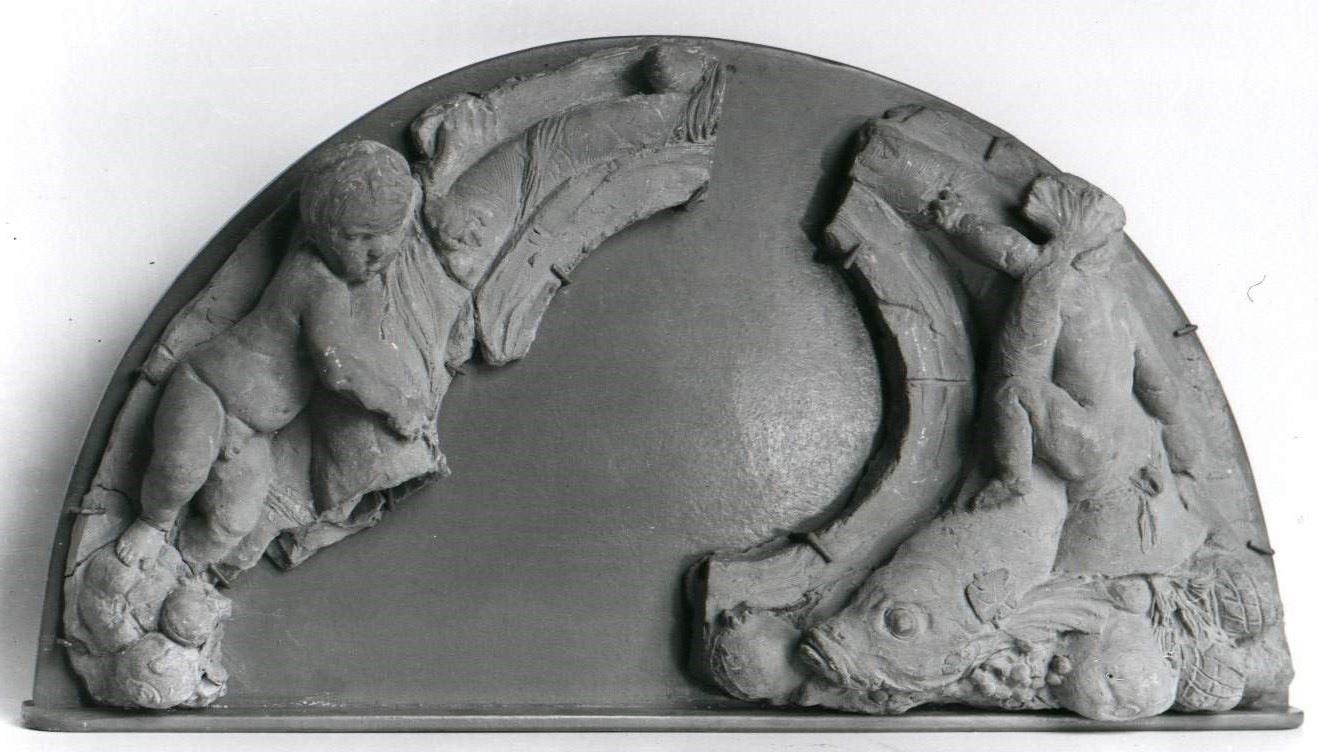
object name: sculpture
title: Model for an Overdoor Lunette with Putti and Fish for the Amsterdam Town Hall (now Royal Palace) at Dam Square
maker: artus quellinus (i)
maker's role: draughtsman, print maker, sculptor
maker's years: 1609-1668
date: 1650-1651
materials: terracotta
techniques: modeling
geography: amsterdam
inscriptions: inscription, on the right fragment, above the cornucopia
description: Het fragment van de linker helft geeft een kind driekwart naar de toeschouwer gekeerd, staande op vruchten en zijdelings geleund tegen een hoorn van overvloed, waar een lint omheen is gewonden. Het heeft de armen om de staart van de vis geslagen. Het fragment van de rechter helft geeft een kind ruggelings gezien, klauterend tegen een hoorn en tegen de staart van een met de kop naar beneden gerichte vis.